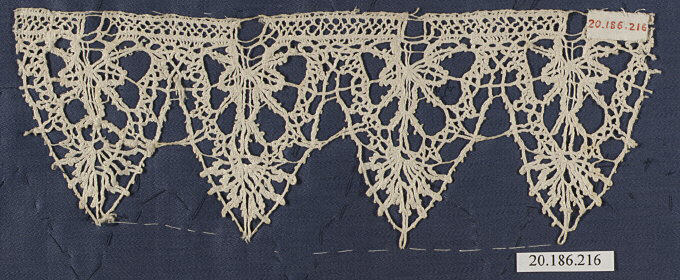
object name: edging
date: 1601-1700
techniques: lace